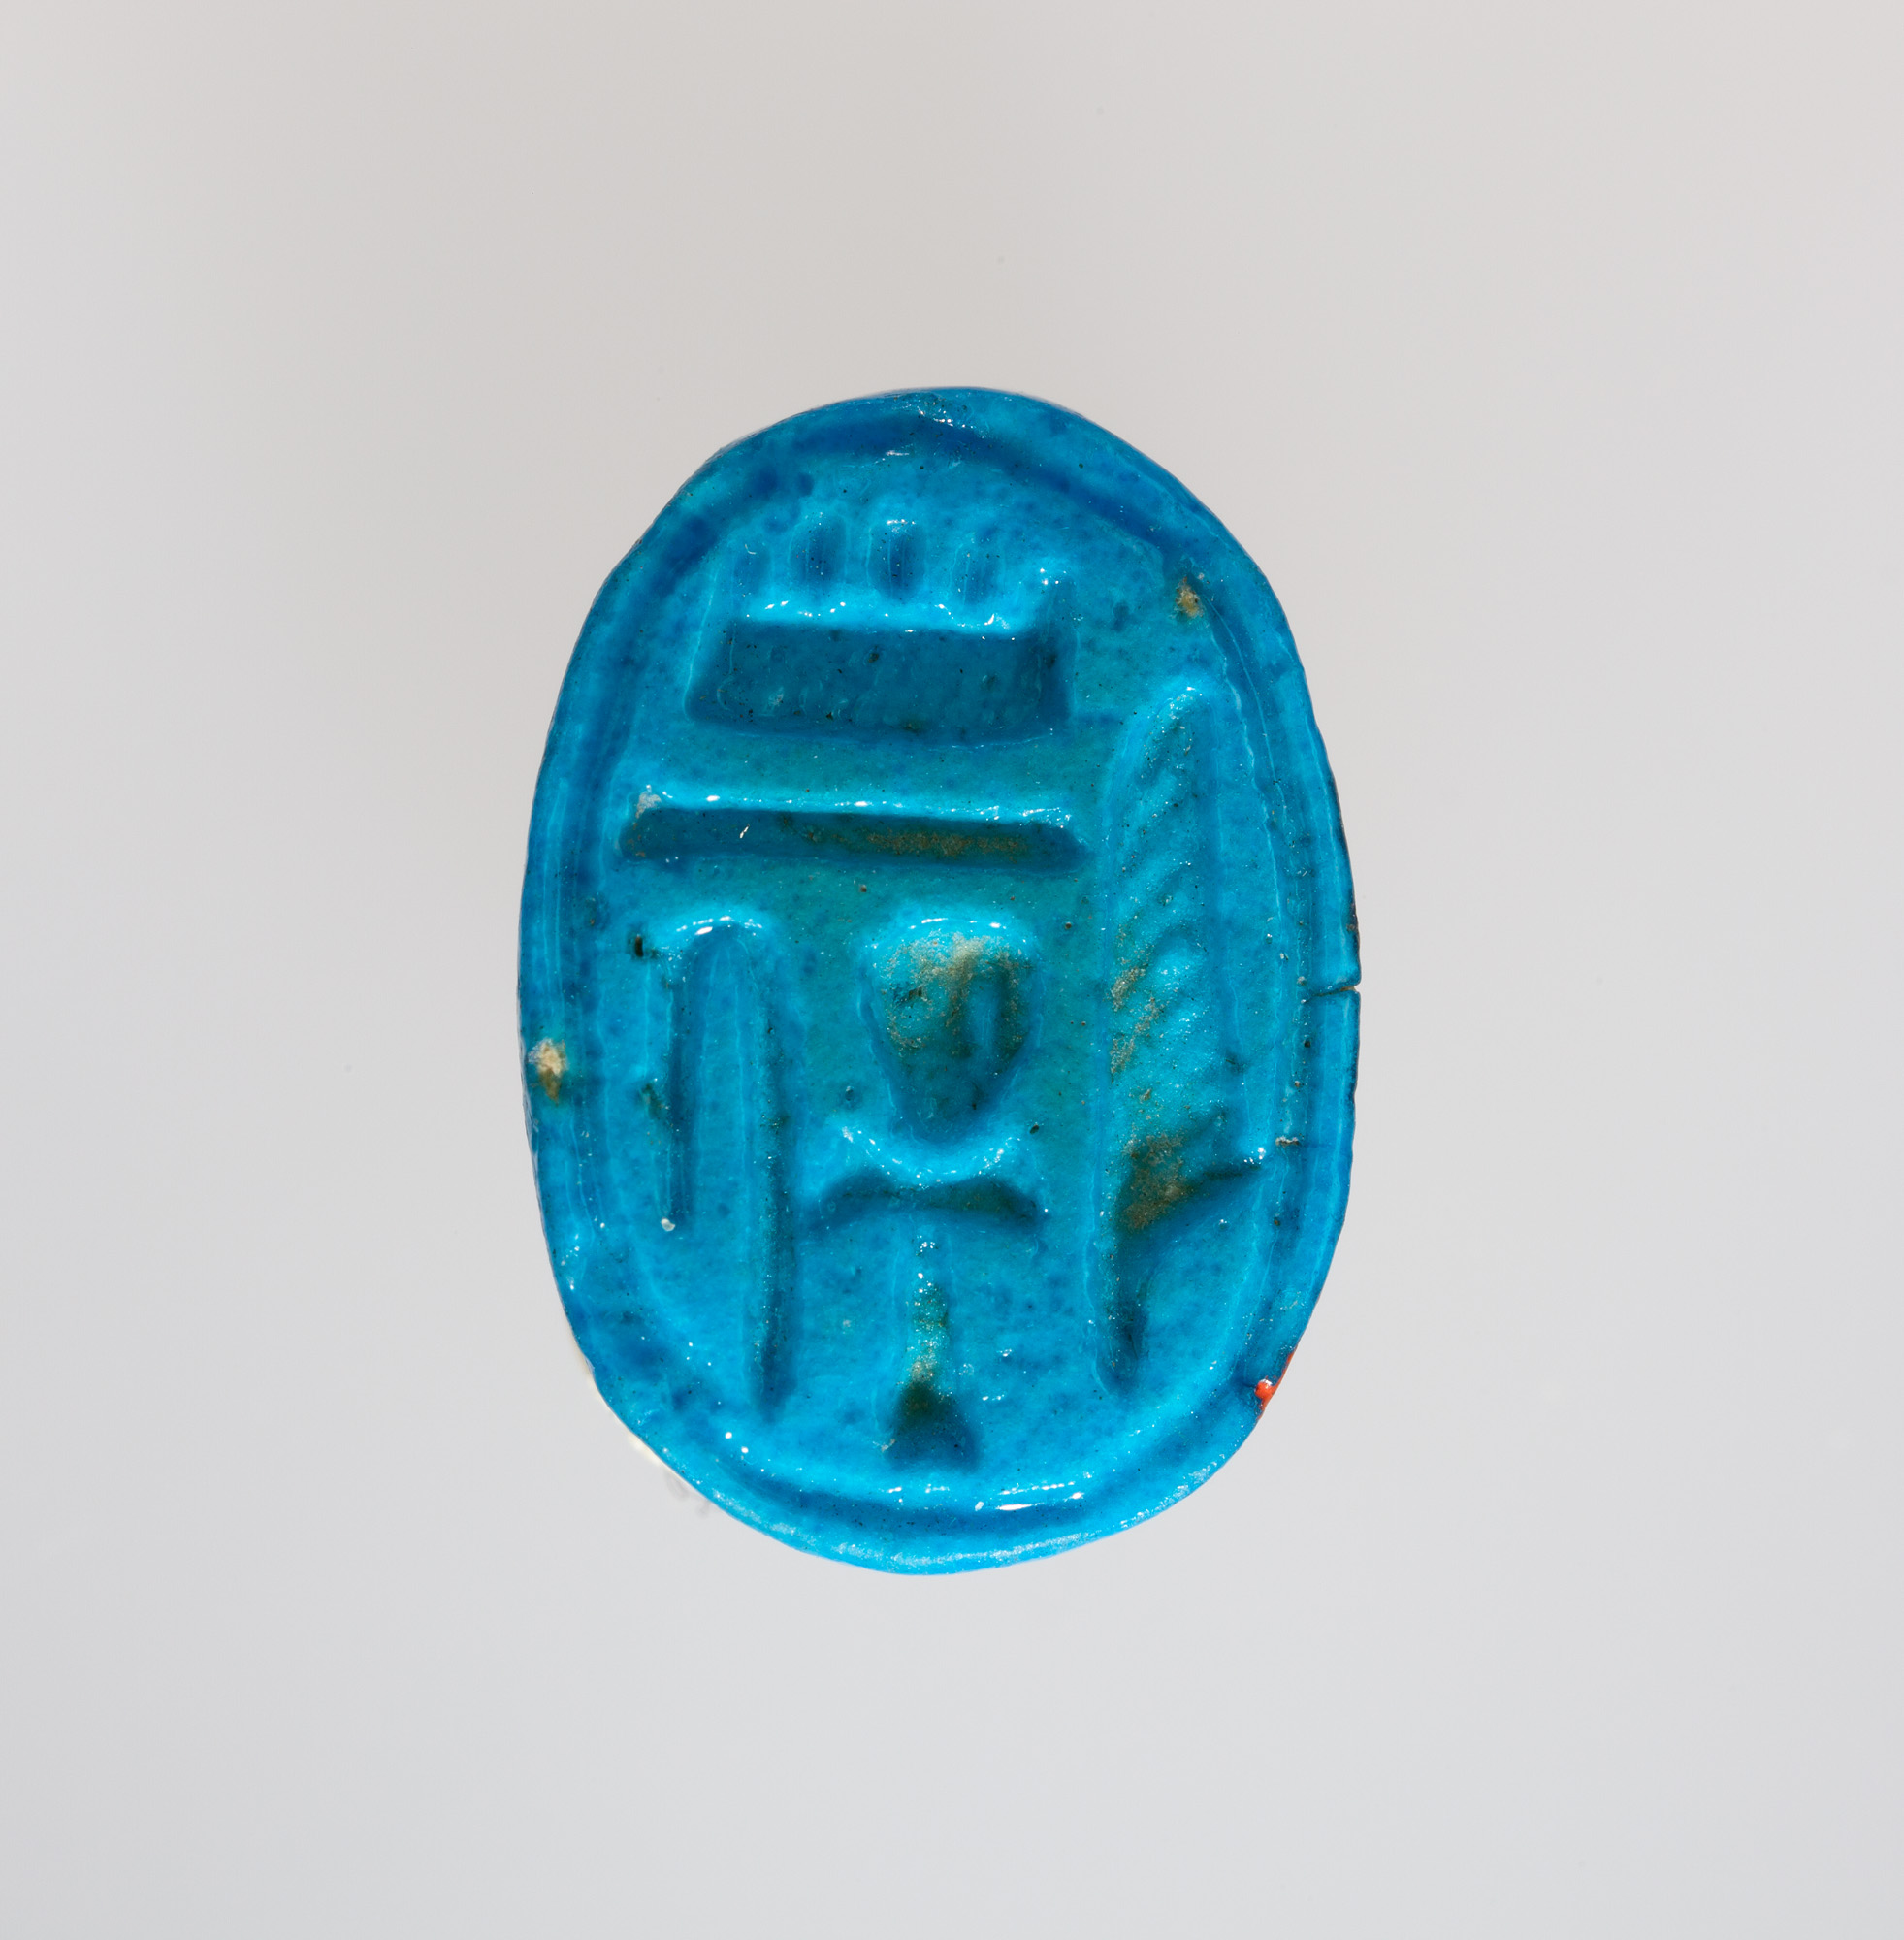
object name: scarab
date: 1479-1458 BCE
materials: faience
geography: egypt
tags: hieroglyphs,scarabs